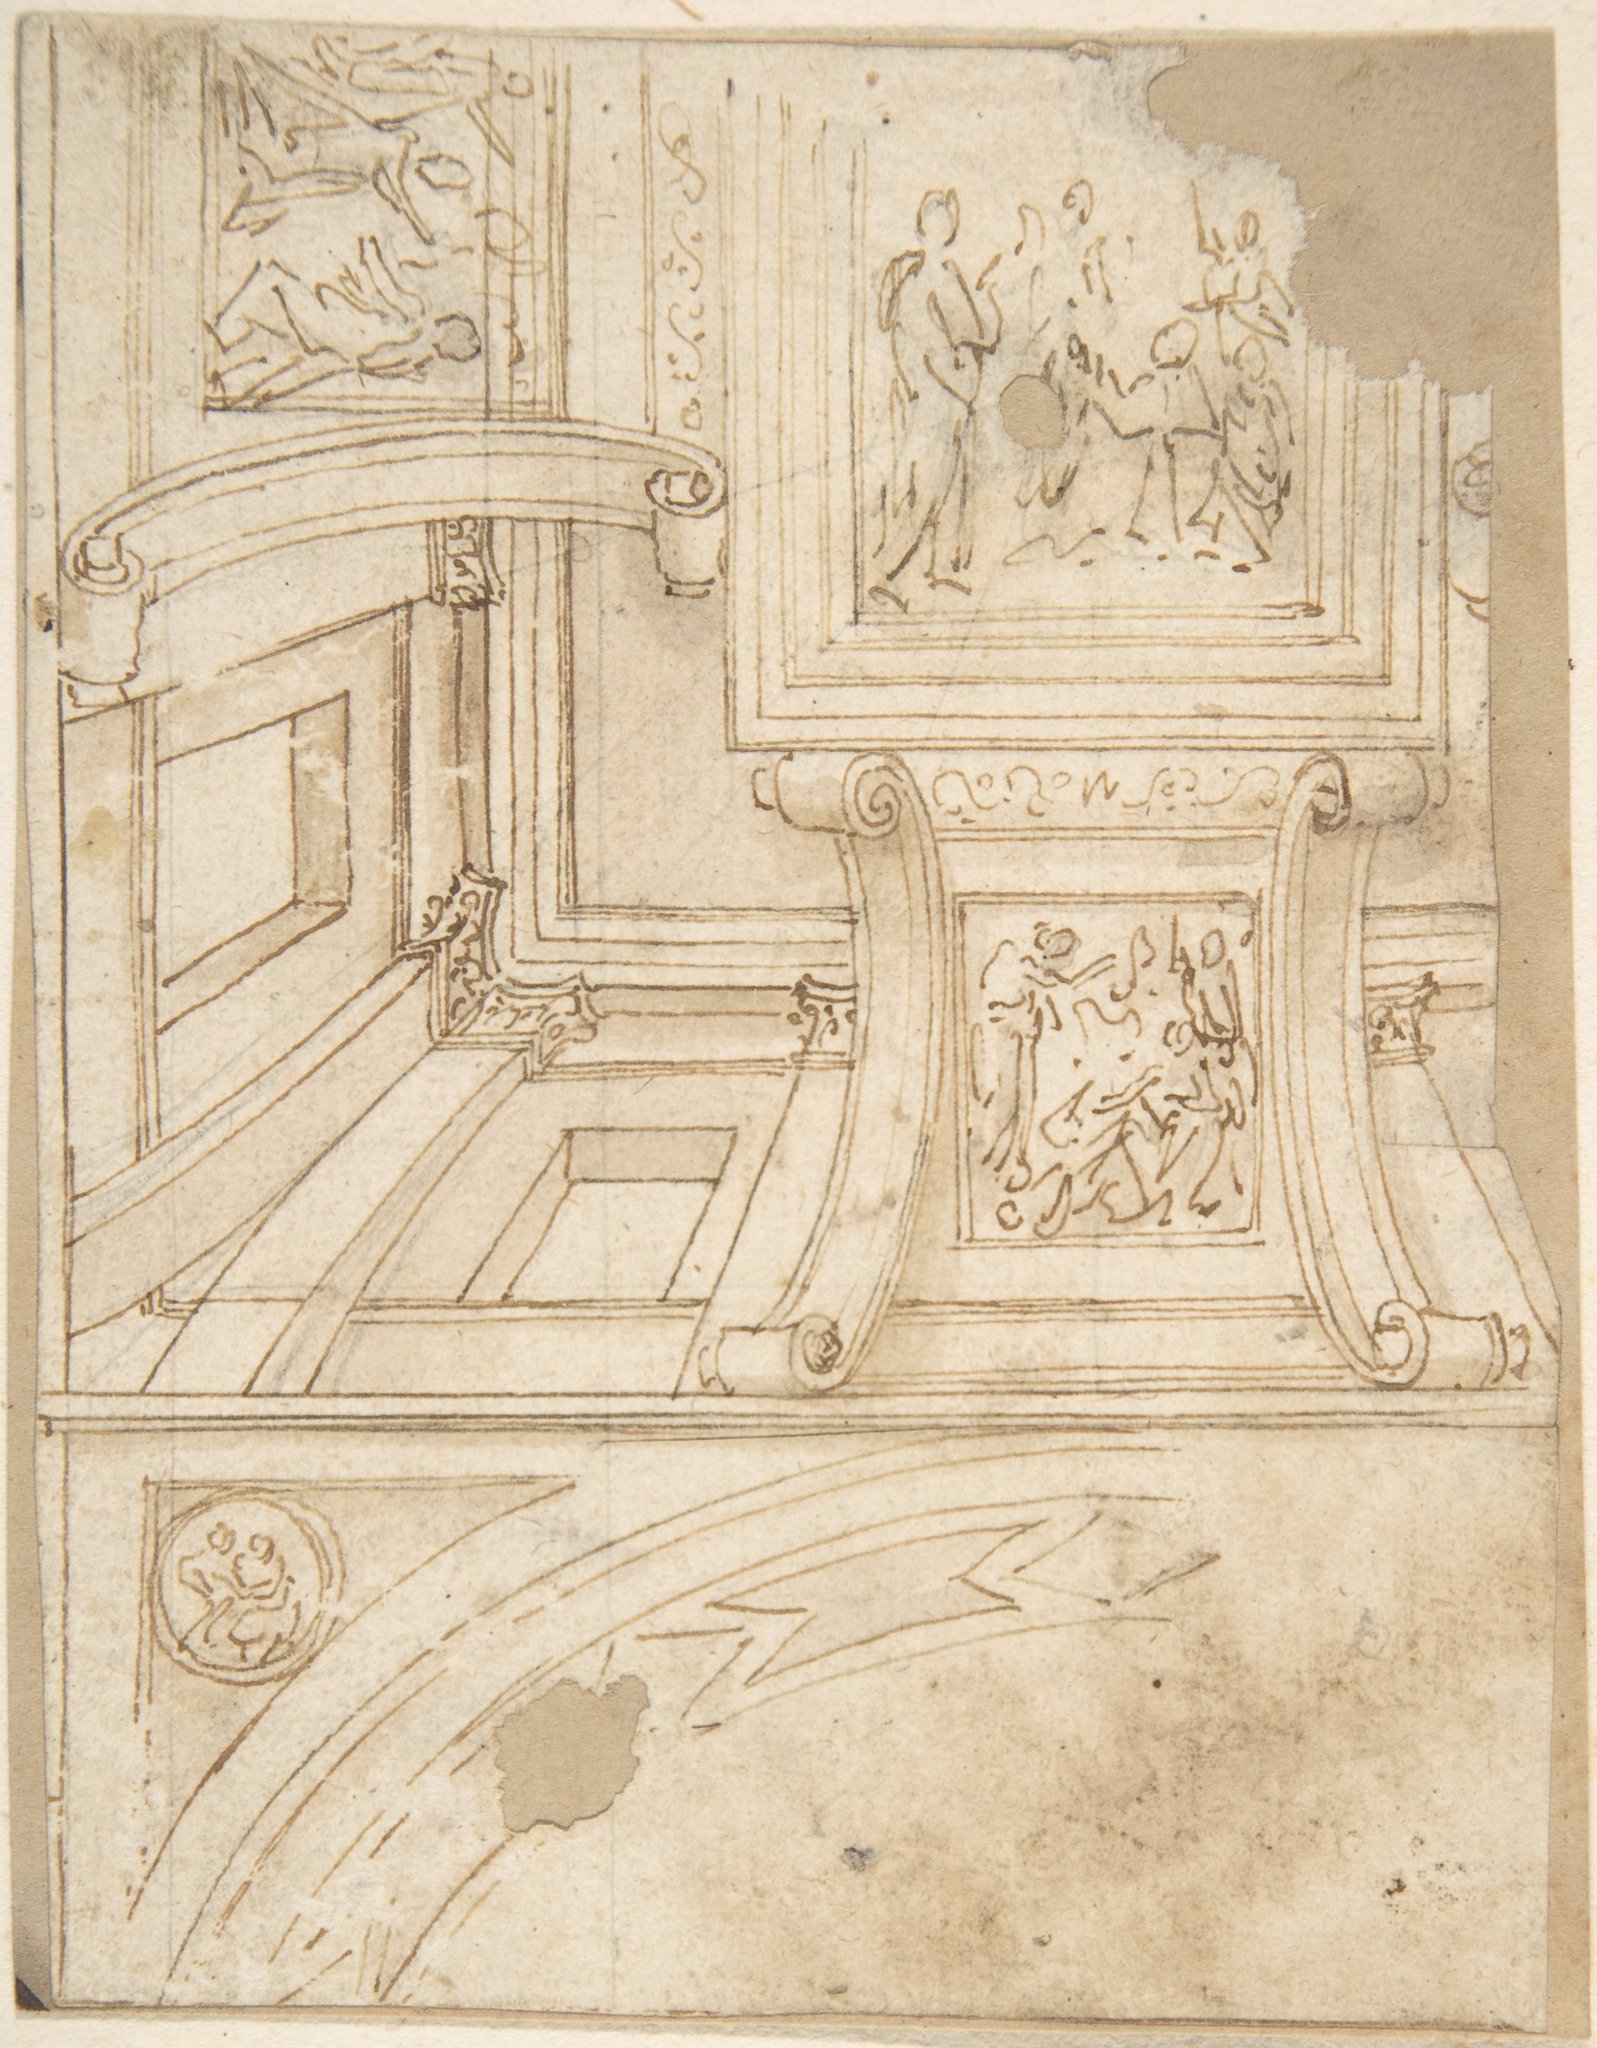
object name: drawing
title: Design for a Ceiling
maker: anonymous, italian, 16th century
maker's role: artist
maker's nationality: italian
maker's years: 1500-1600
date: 1520-1550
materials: ink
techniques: brush, pen, wash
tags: ceilings